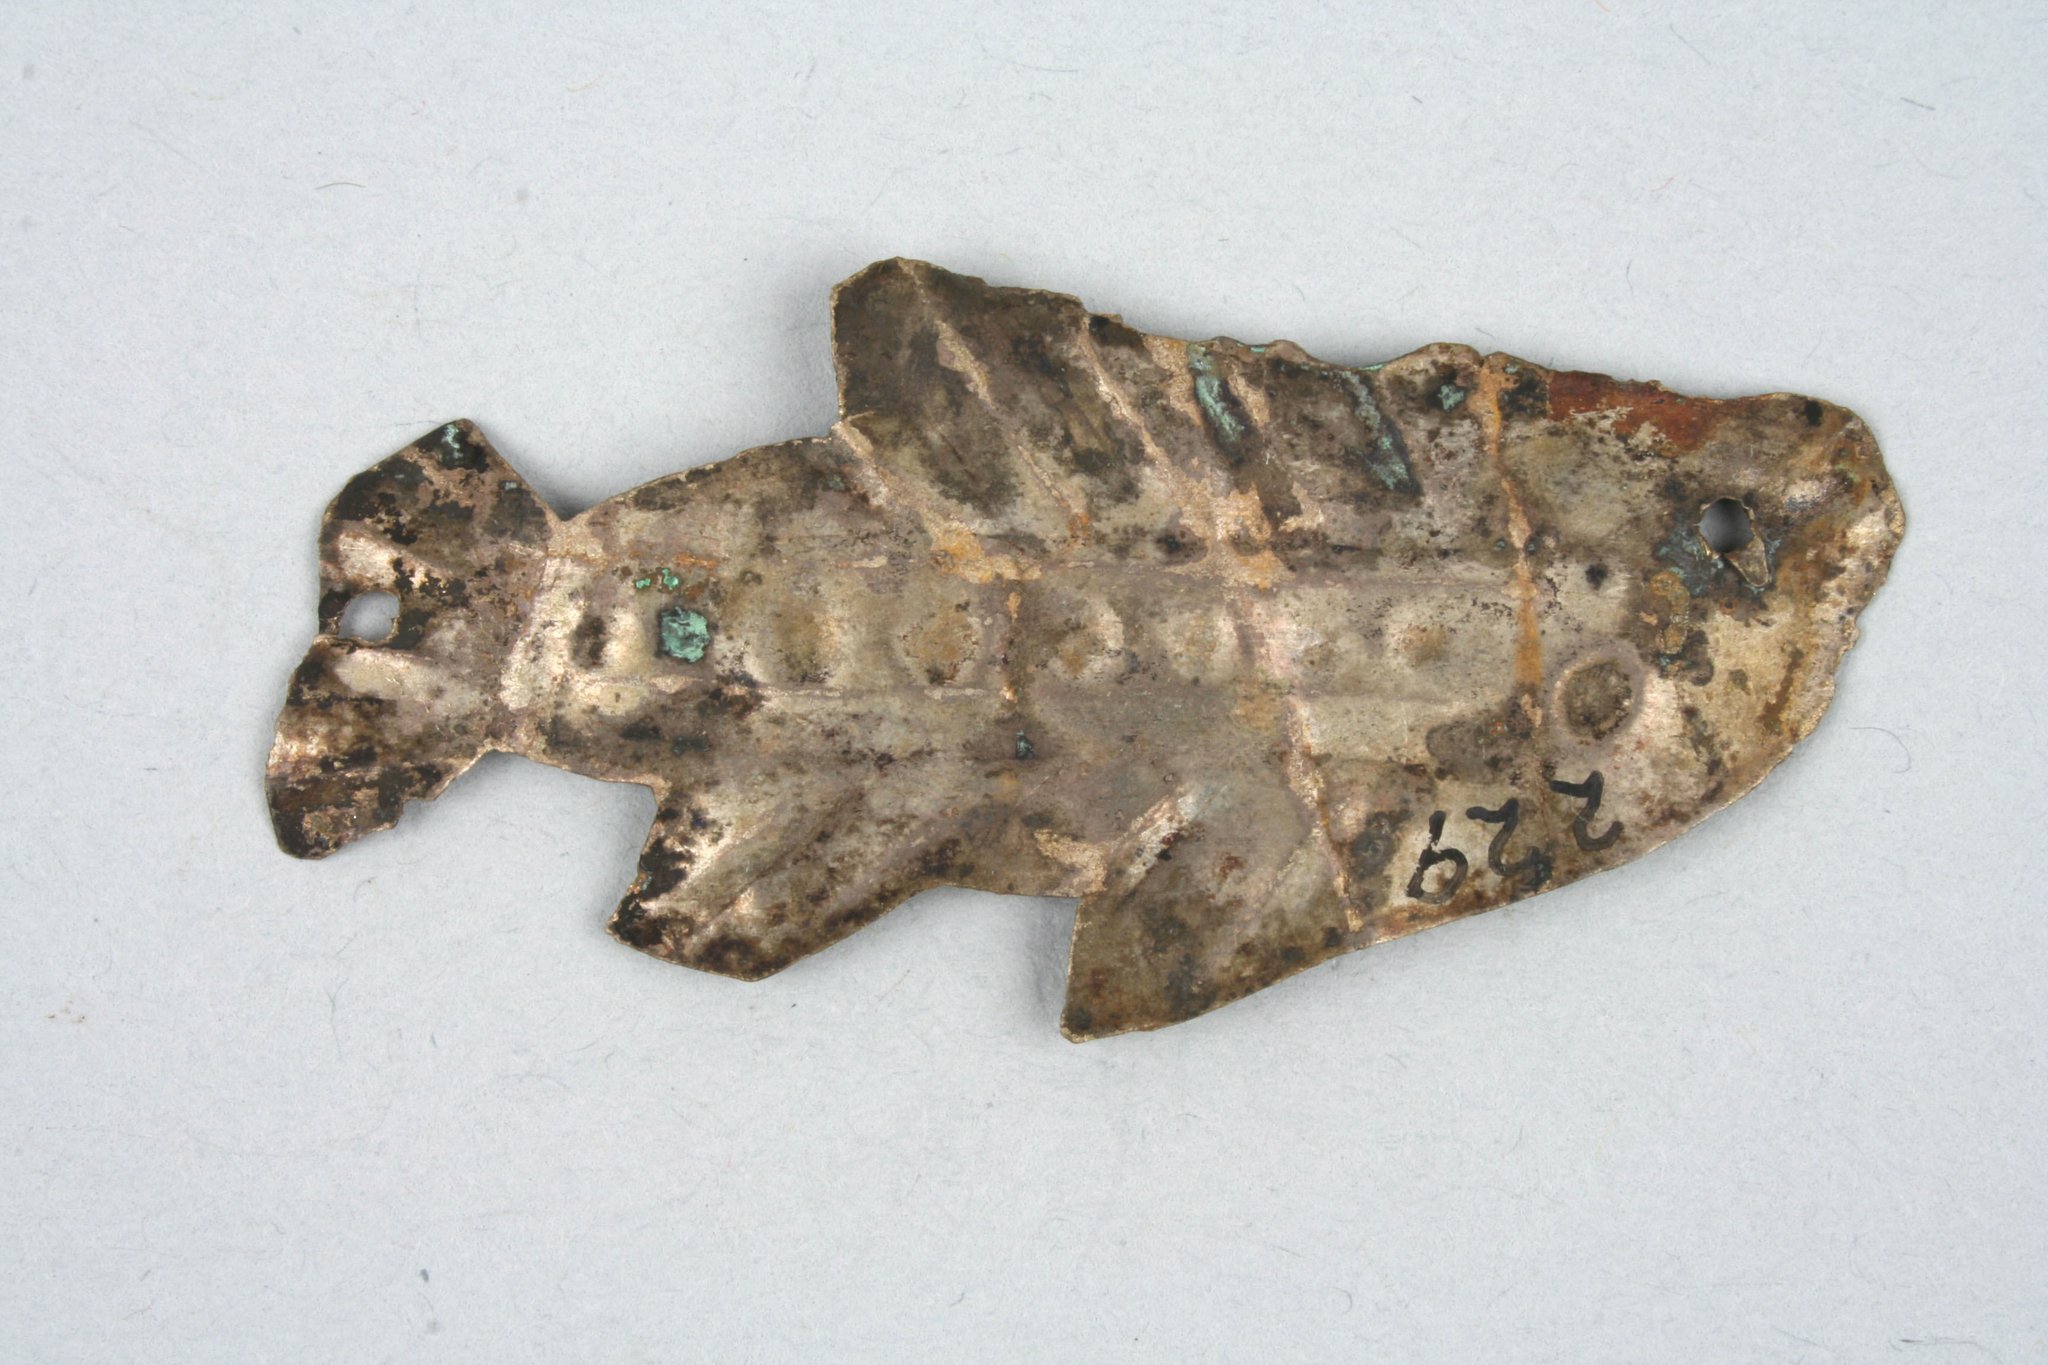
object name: costume ornament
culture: peruvian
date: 1001-1200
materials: silver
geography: peru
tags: fish